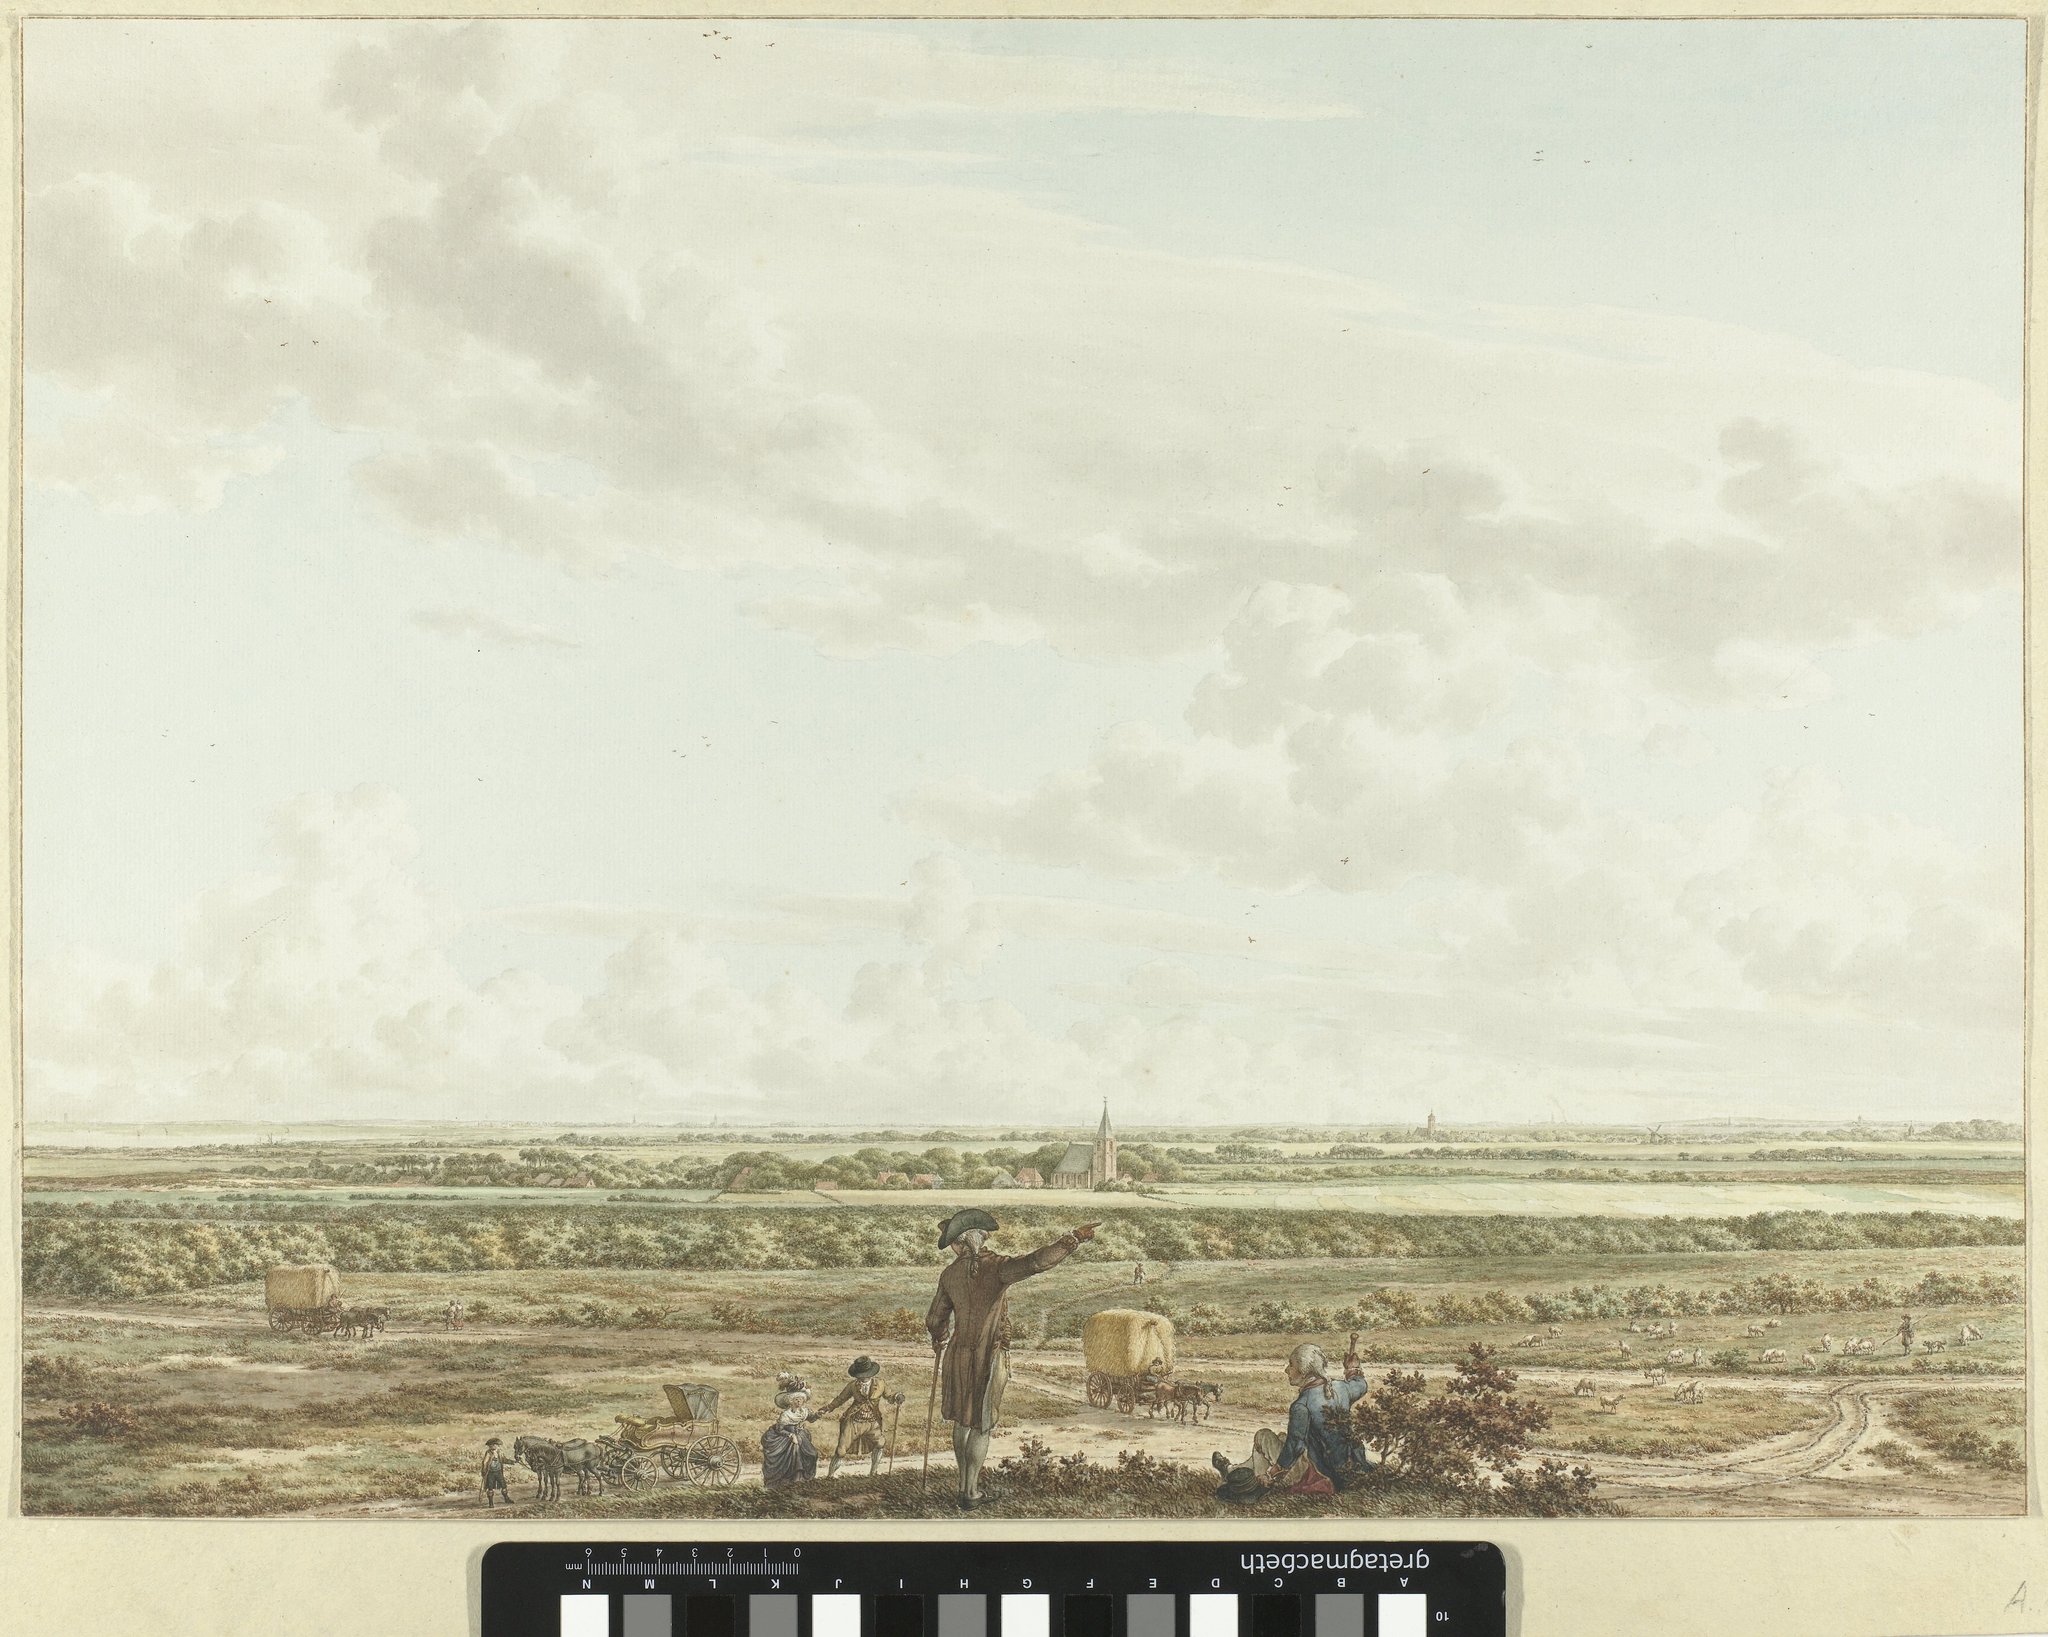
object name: drawing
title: View of the Tafelberg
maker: jacob cats (1741-1799)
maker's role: draughtsman, print maker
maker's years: 1741-1799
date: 1795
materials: ink, paper, watercolor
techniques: brush, pen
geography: amsterdam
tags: landscapes in the temperate zone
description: This panorama invites viewers to lose themselves in it. In the kilometres-wide landscape we come across travellers, hunters and a shepherd with his flock of sheep. With its view – on one side stretching over the heaths and on the other over fields with the Utrecht Hill Ridge in the distance – the Tafelberg was a popular destination for day-trippers.